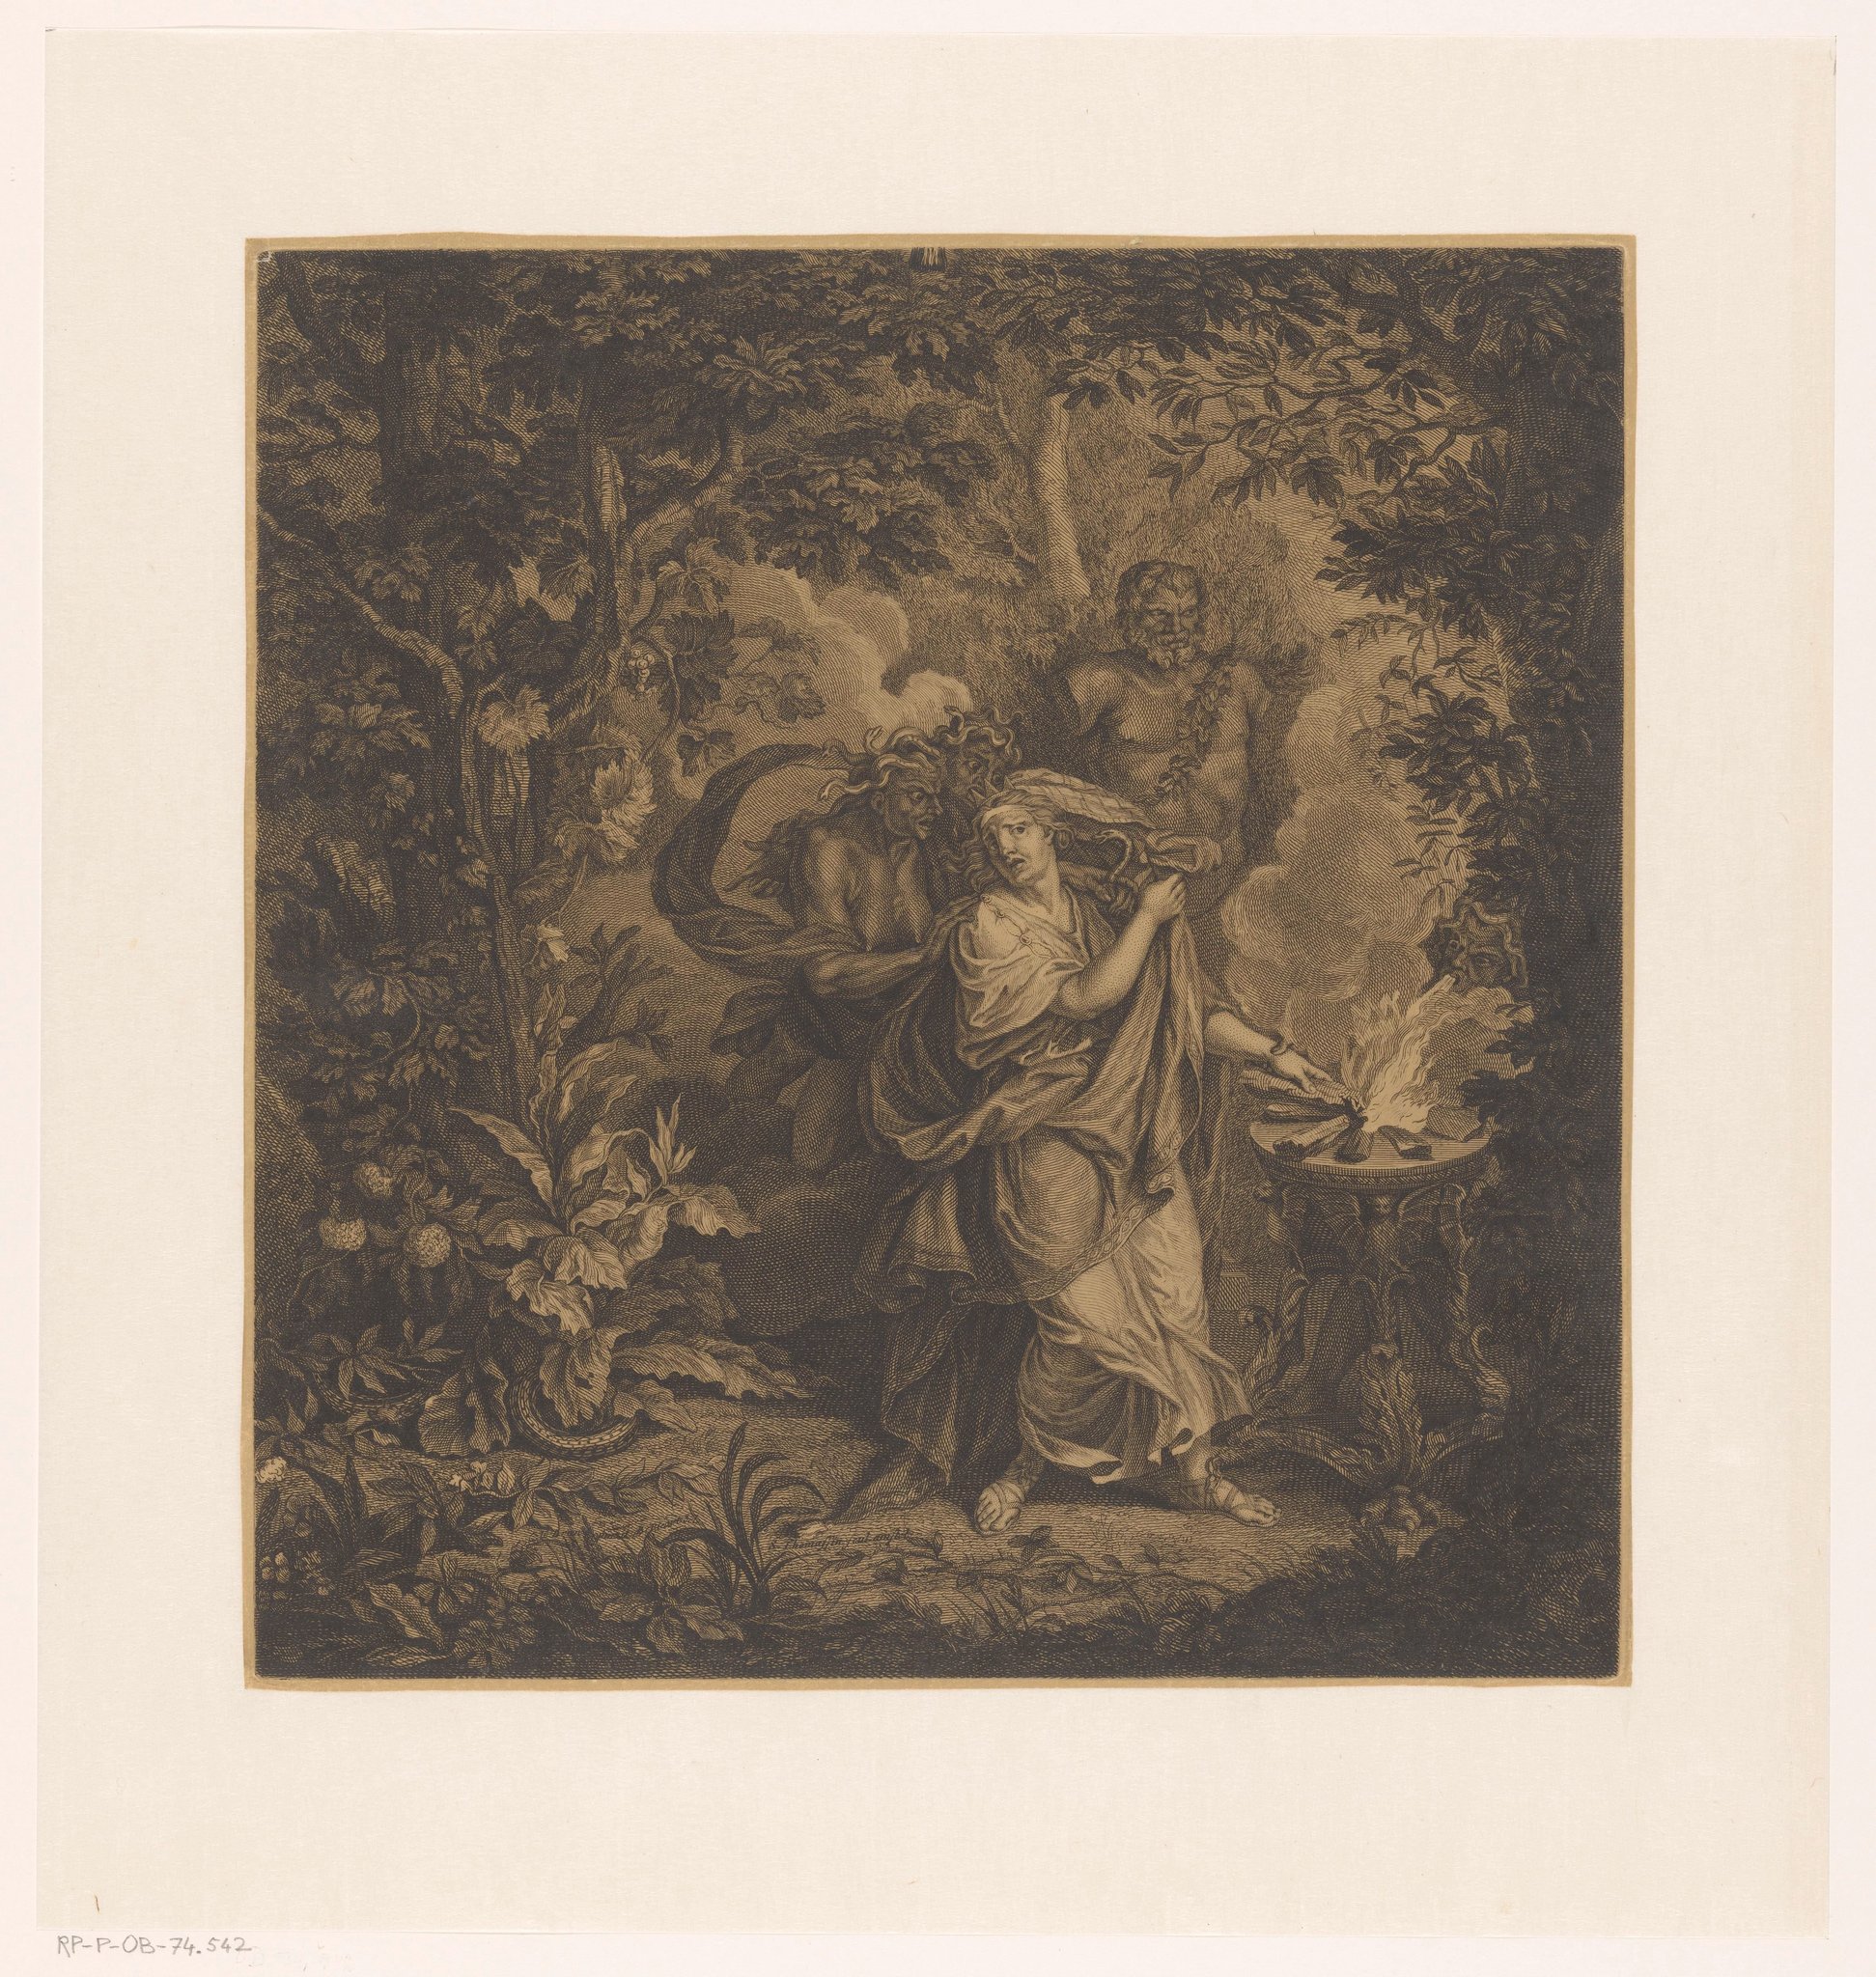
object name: print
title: Mythologische scène met een offerende koningin in een bos, mogelijk Althaea, en drie gorgonen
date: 1697-1741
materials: paper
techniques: engraving, etching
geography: amsterdam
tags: gorgons, queen, sacrifice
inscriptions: collector's mark: Lugt 240